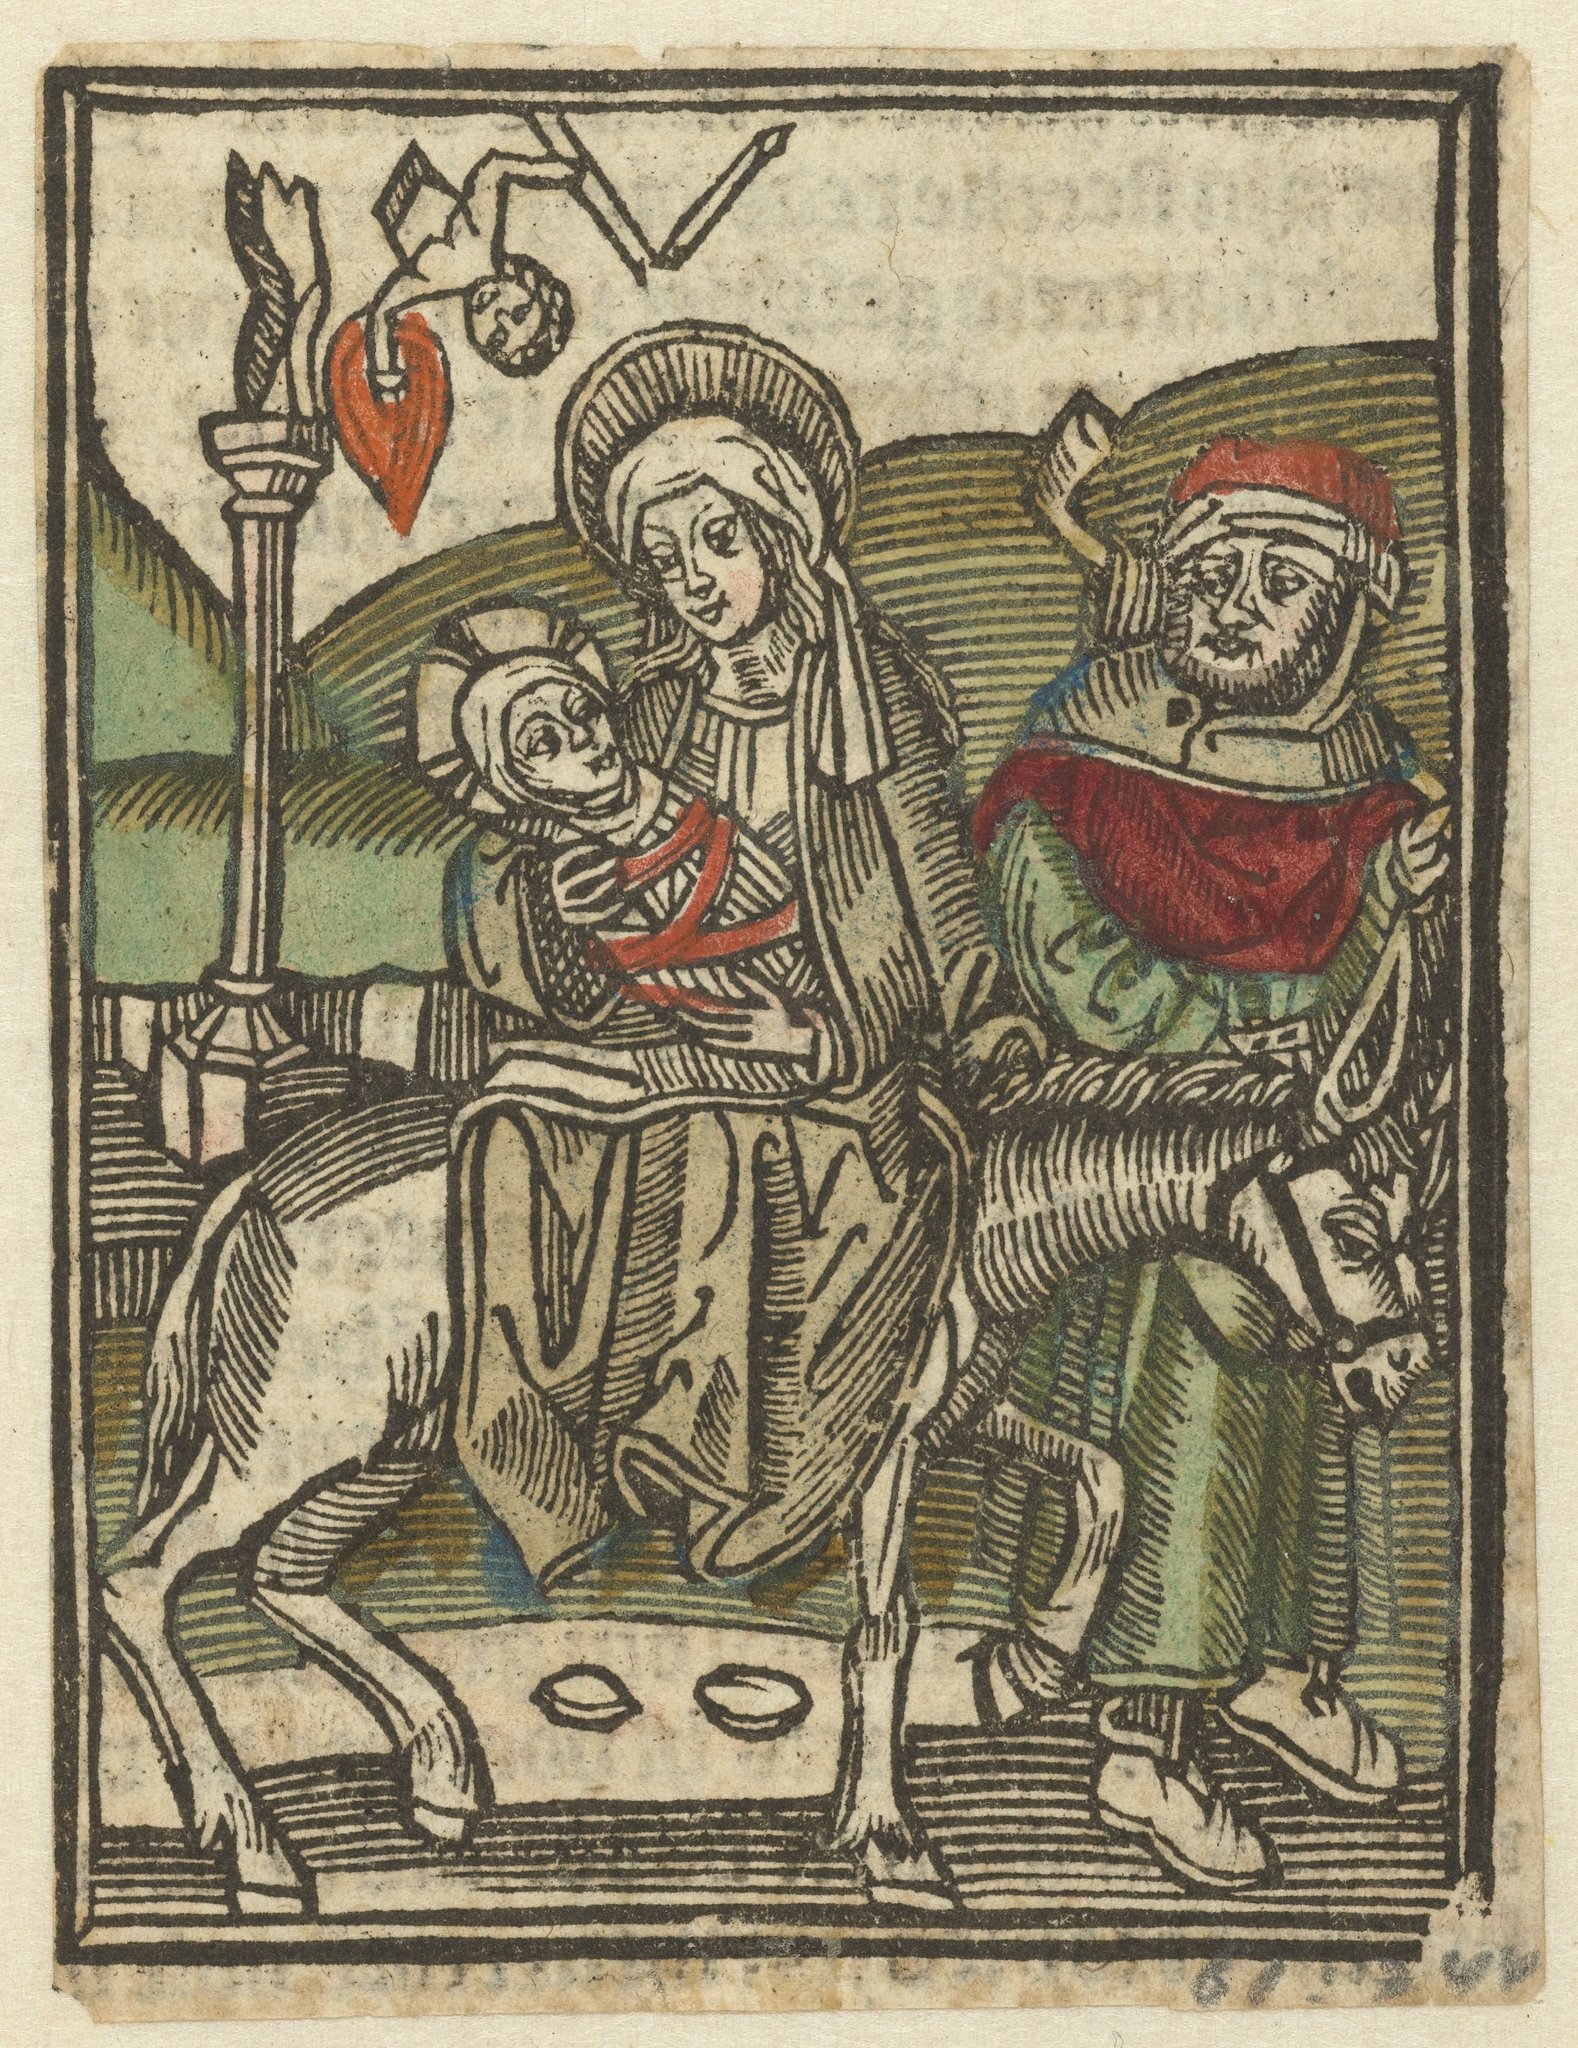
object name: print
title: De vlucht naar Egypte met het vallend afgodsbeeld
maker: Anonymous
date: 1480-1500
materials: paper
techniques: hand coloring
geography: low countries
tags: the flight into egypt: mary, joseph, the child (and sometimes others) on their way; mary usually riding on an ass, statues, paintings, etc. ~ objects of worship in roman religion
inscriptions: collector's mark: Lugt 2228a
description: Eén van 46 houtsnedes uit Ludolphus de Saxonia "Tboeck vandan leven ons heeren Jesu Christi", een anonieme Nederlandse vertaling. Deze versie van het werk van Ludolphus bevat houtsneden van de Meester van Gouda (II), de Meester van Antwerpen (I) en de Meester van Haarlem, maar van deze houtsnede is de vervaardiger onbekend en is waarschijnlijk een toevoeging bij een latere versie. Botke, K. Boek van Ludolphus is voor het eerst uitgegeven in 1487 door Geeraert Leeu te Antwerpen. In 1488 uitgegeven door Claes Leeu te Antwerpen, in 1495 en 1499 en 1519 door Peter van Os te Zwolle en in 1510 door A. van Berghen te Antwerpen. Deze 46 houtsneden komen waarschijnlijk uit een uitgave van Peter van Os. Botke, K.